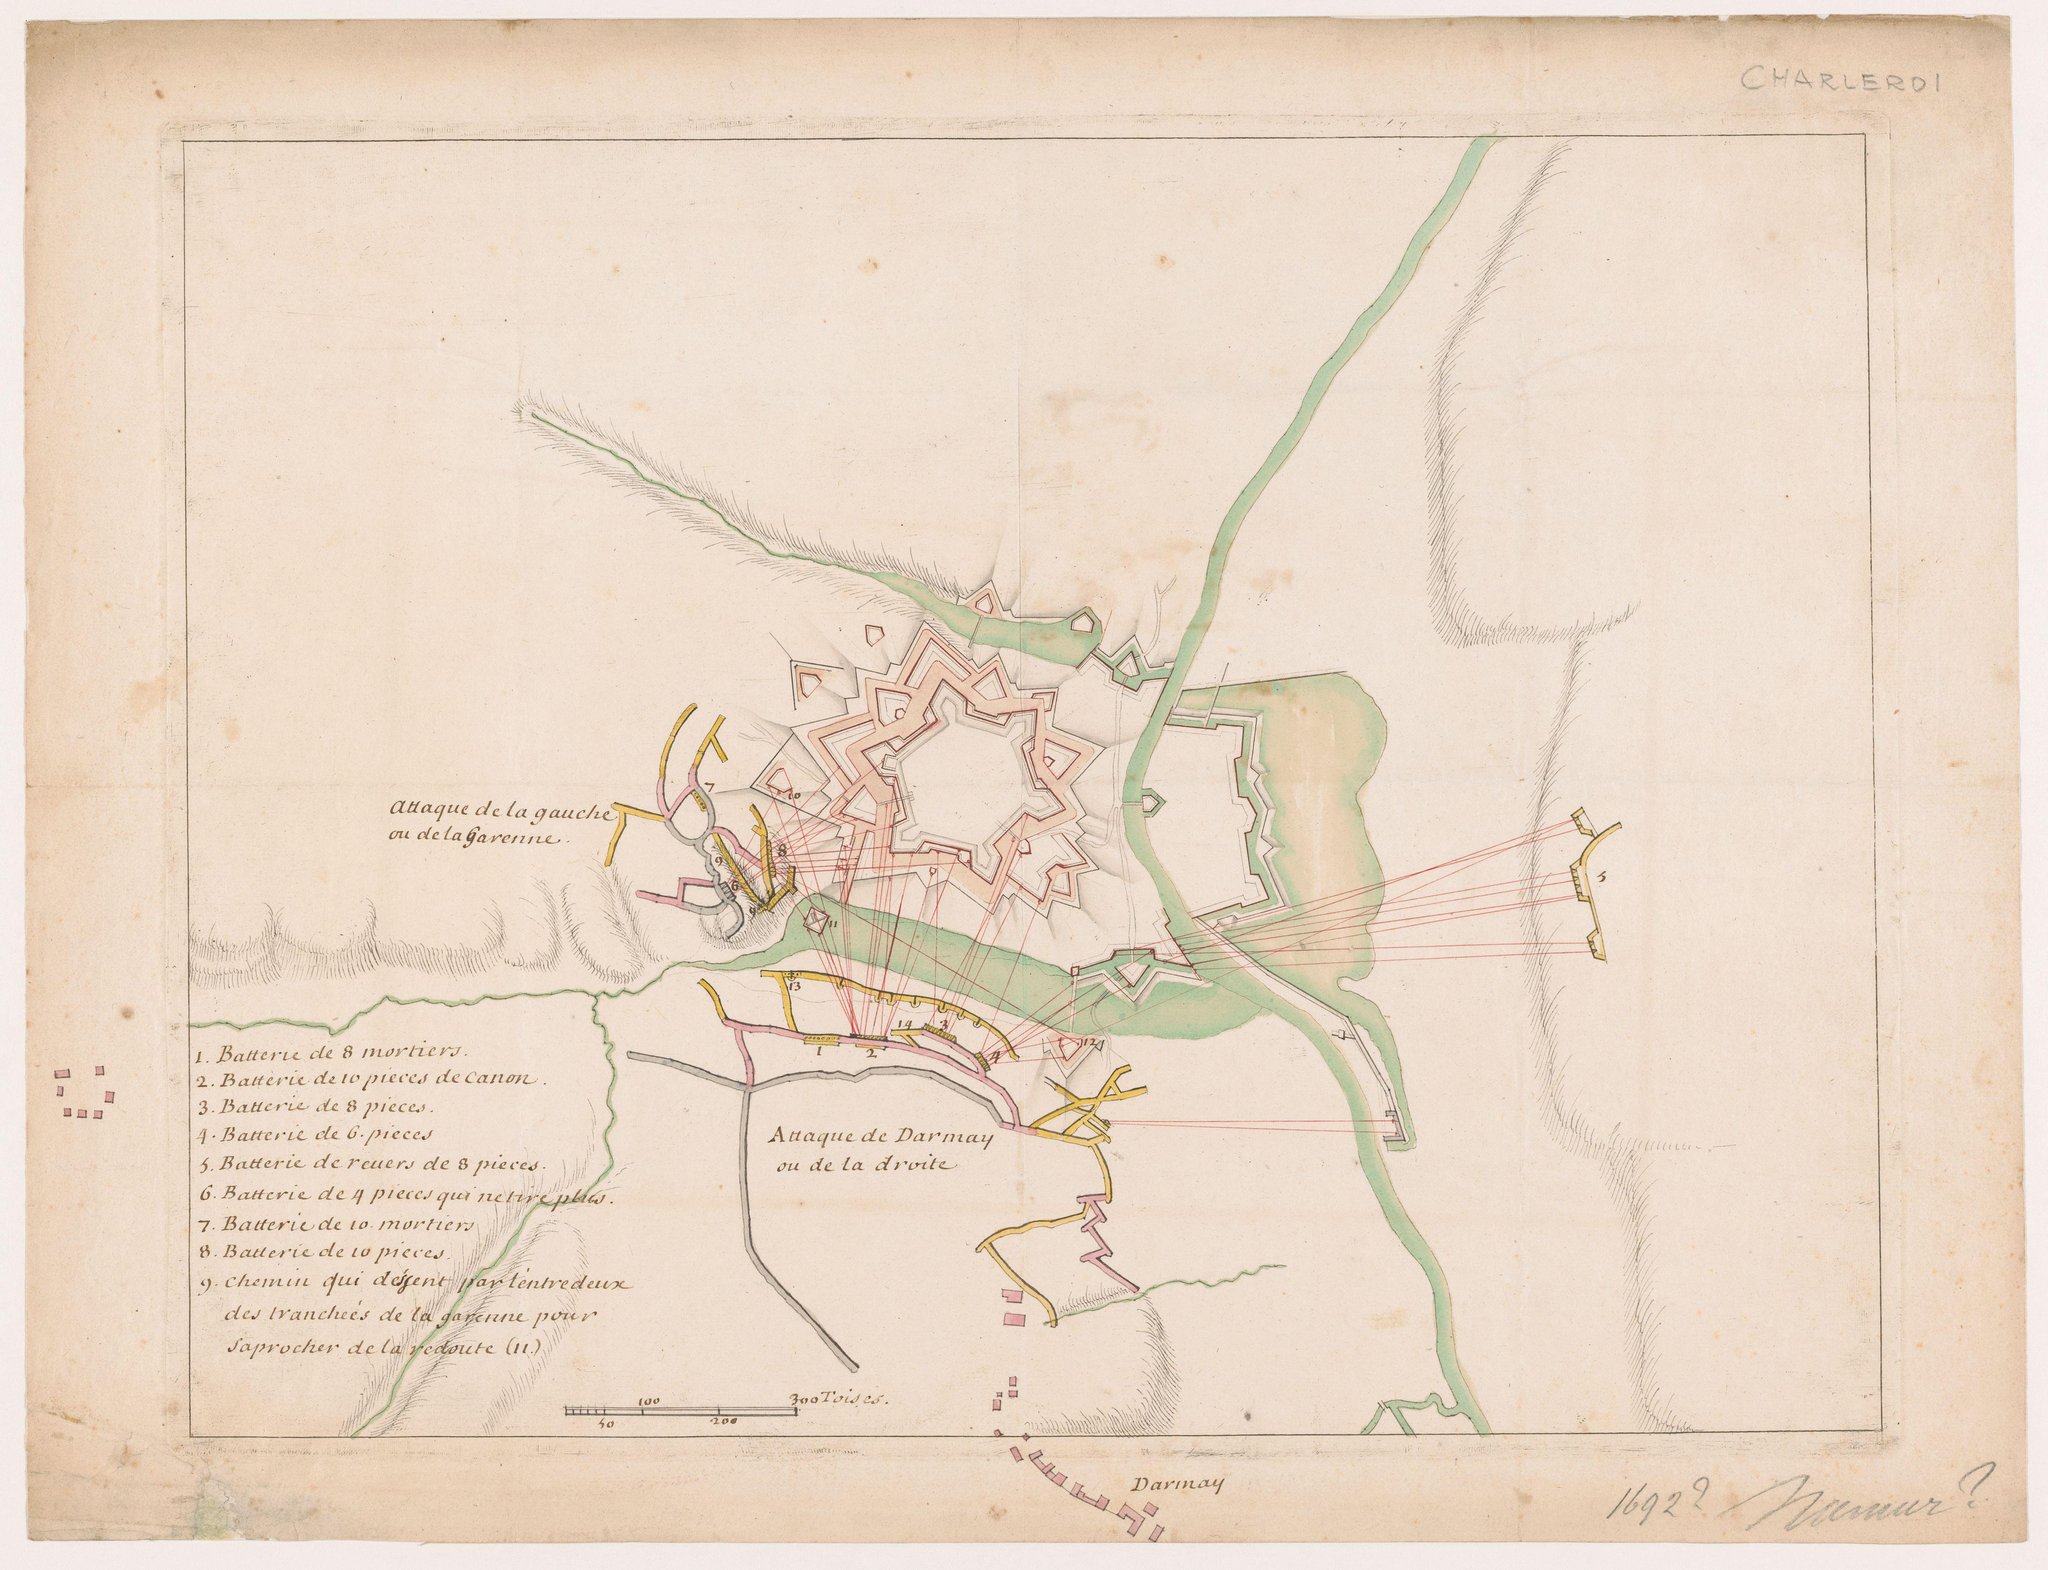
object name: area plan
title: Belegeringsplattegrond van Namen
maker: Anonymous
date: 1692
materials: ink, paper, watercolor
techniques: brush, pen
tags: fortified city, siege, bombardment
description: Hoewel er een plaatrand om de afbeelding heen zit, lijken alle lijnen op de prent getekend te zijn. Mogelijk is dit het ontwerp voor een prent.